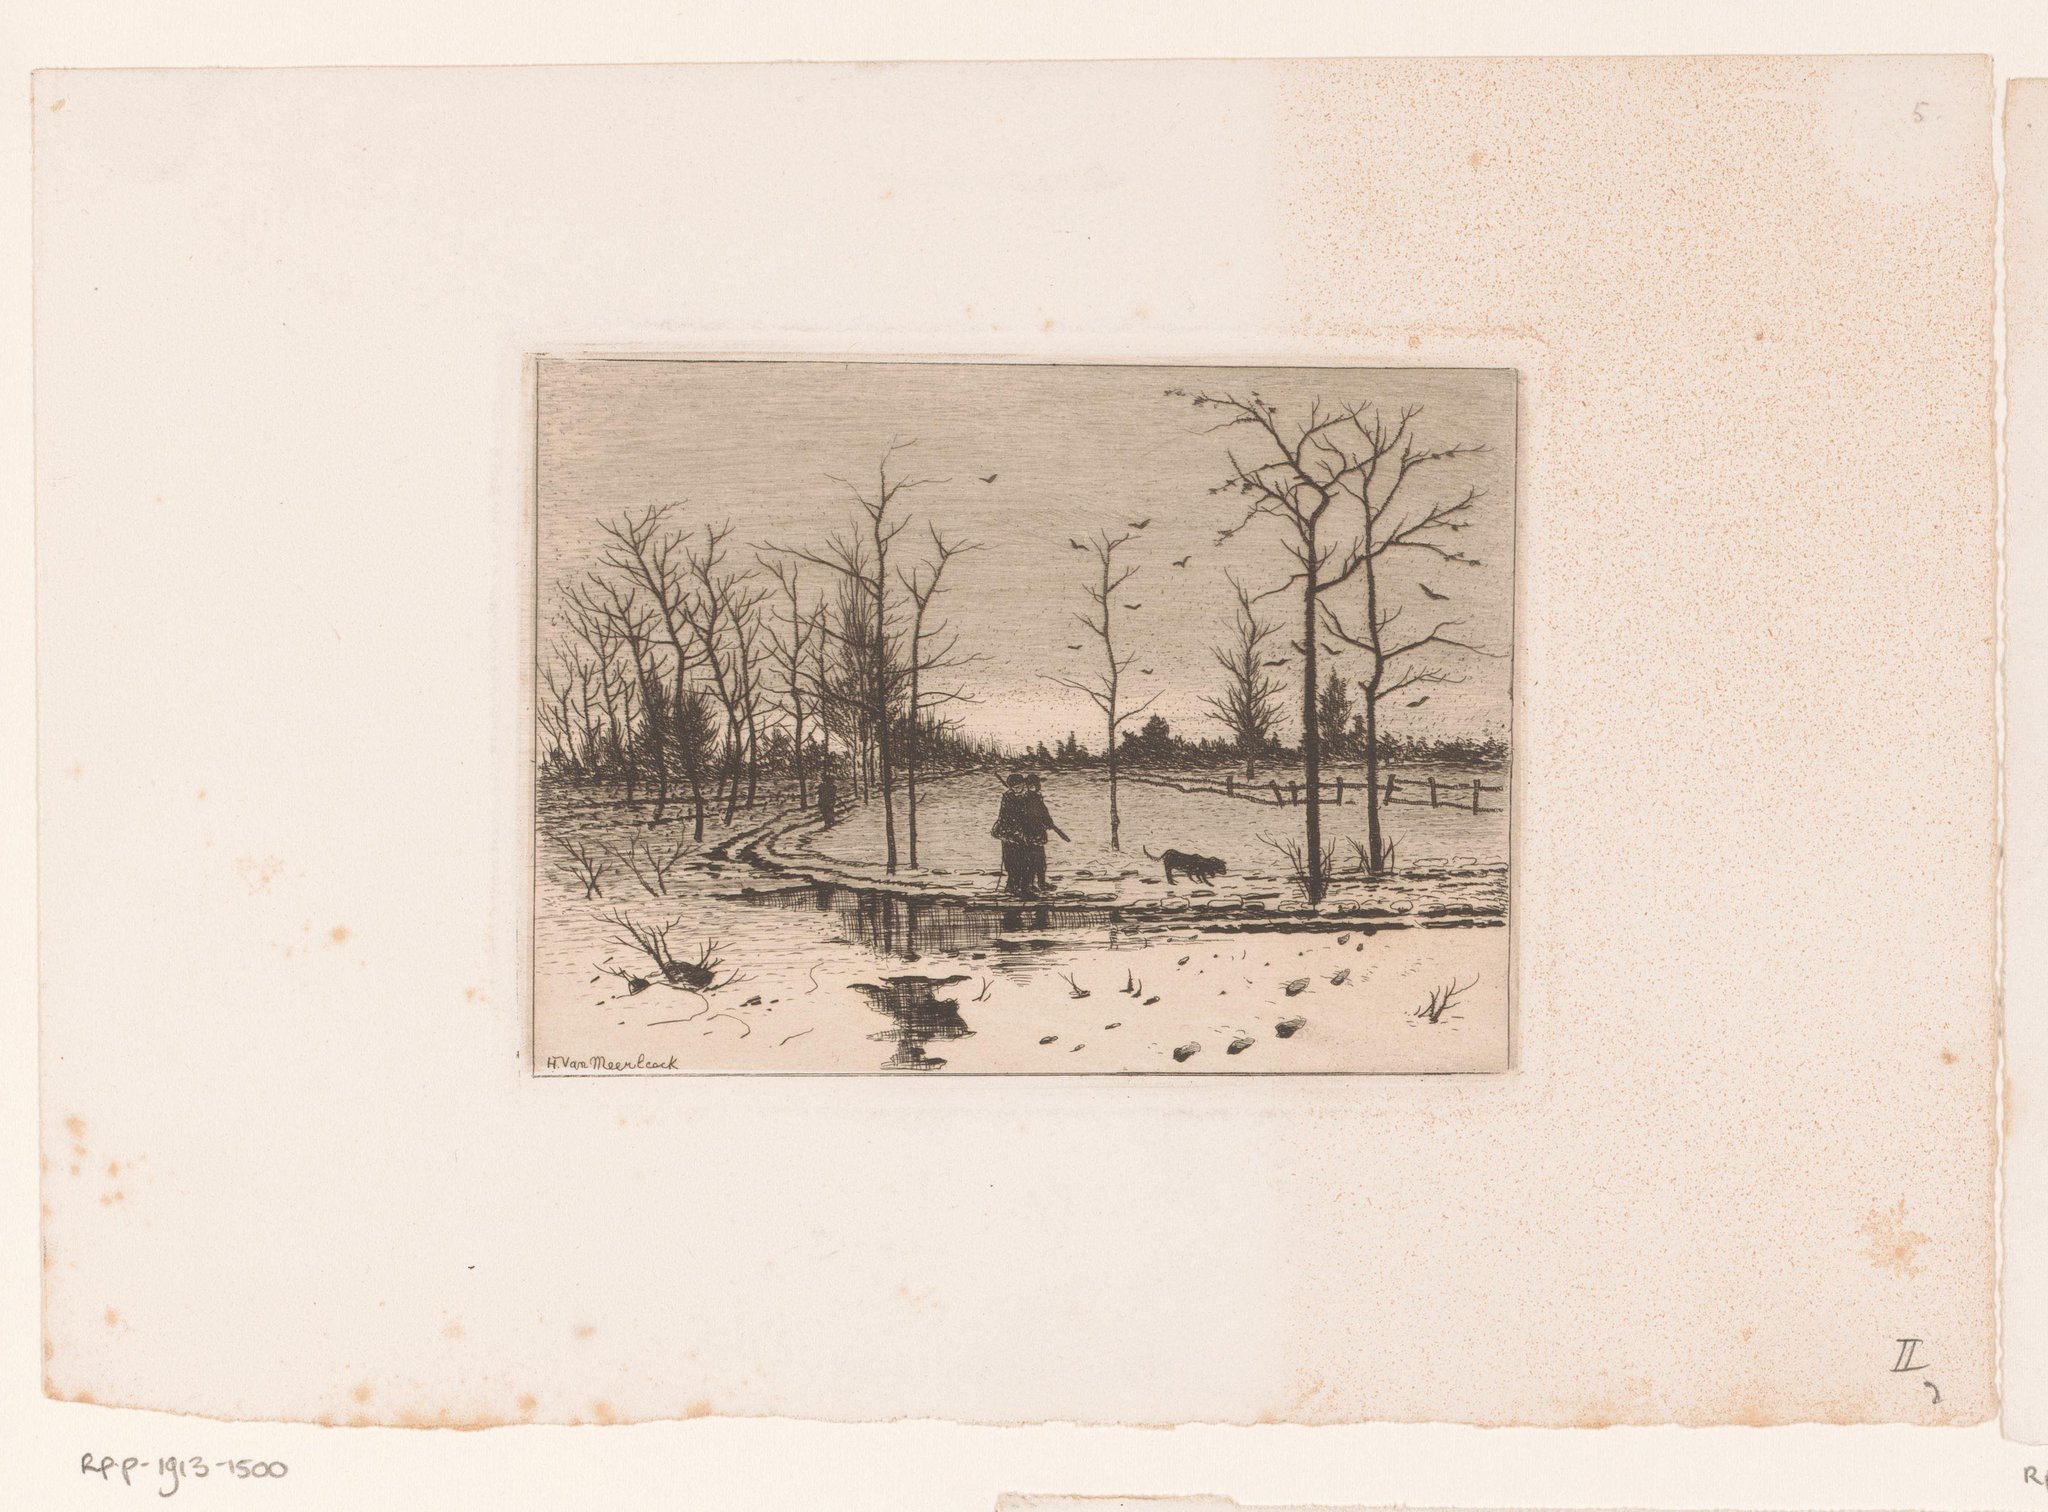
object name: print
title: Winterlandschap met jagers en een hond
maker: h. van meerbeeck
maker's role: print maker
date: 1850-1913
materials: paper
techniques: etching, intaglio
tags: hunters hunting (n.b.: in 1988-1990 this notation denoted the concept of 43c11421 'hunters resting during the hunt'), winter landscape; landscape symbolizing winter (the four seasons of the year), dog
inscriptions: collector's mark: Lugt 2228